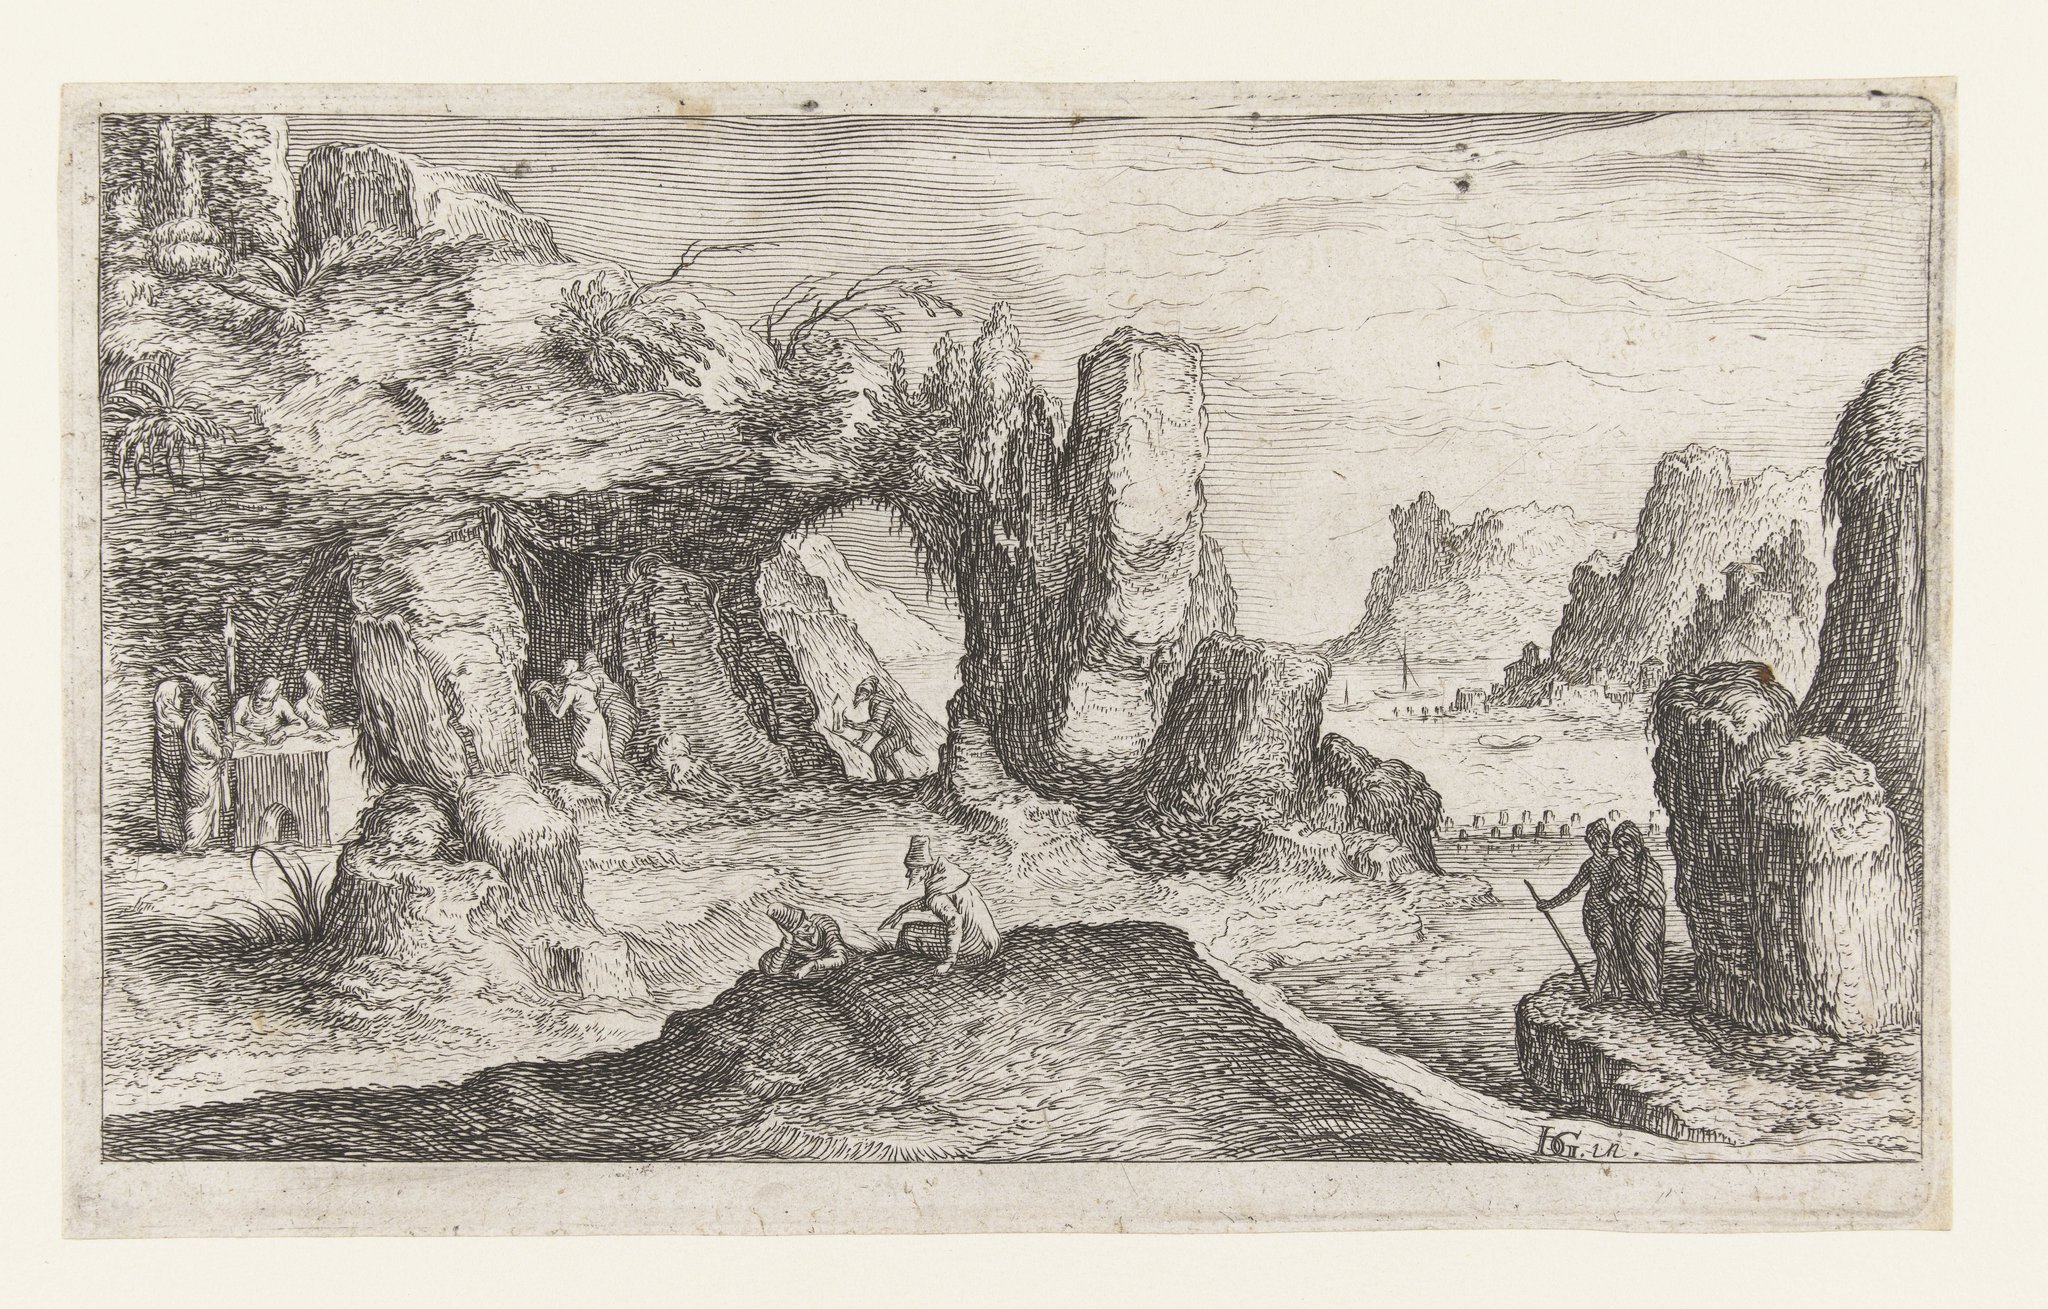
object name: print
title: Landschap met figuren bij een grot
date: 1608-1612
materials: paper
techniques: engraving, etching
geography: netherlands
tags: landscapes, cave, grotto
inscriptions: collector's mark: Lugt 240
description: Bergachtig landschap aan een water. Links een grot waarin figuren knielen en waaromheen figuren aan een tafel staan/zitten, met elkaar praten en rondlopen. Onder de voorstelling is ruimte wit gelaten voor een regel tekst. Deze prent is onderdeel van een serie van zes (op één na) genummerde prenten met landschappen.